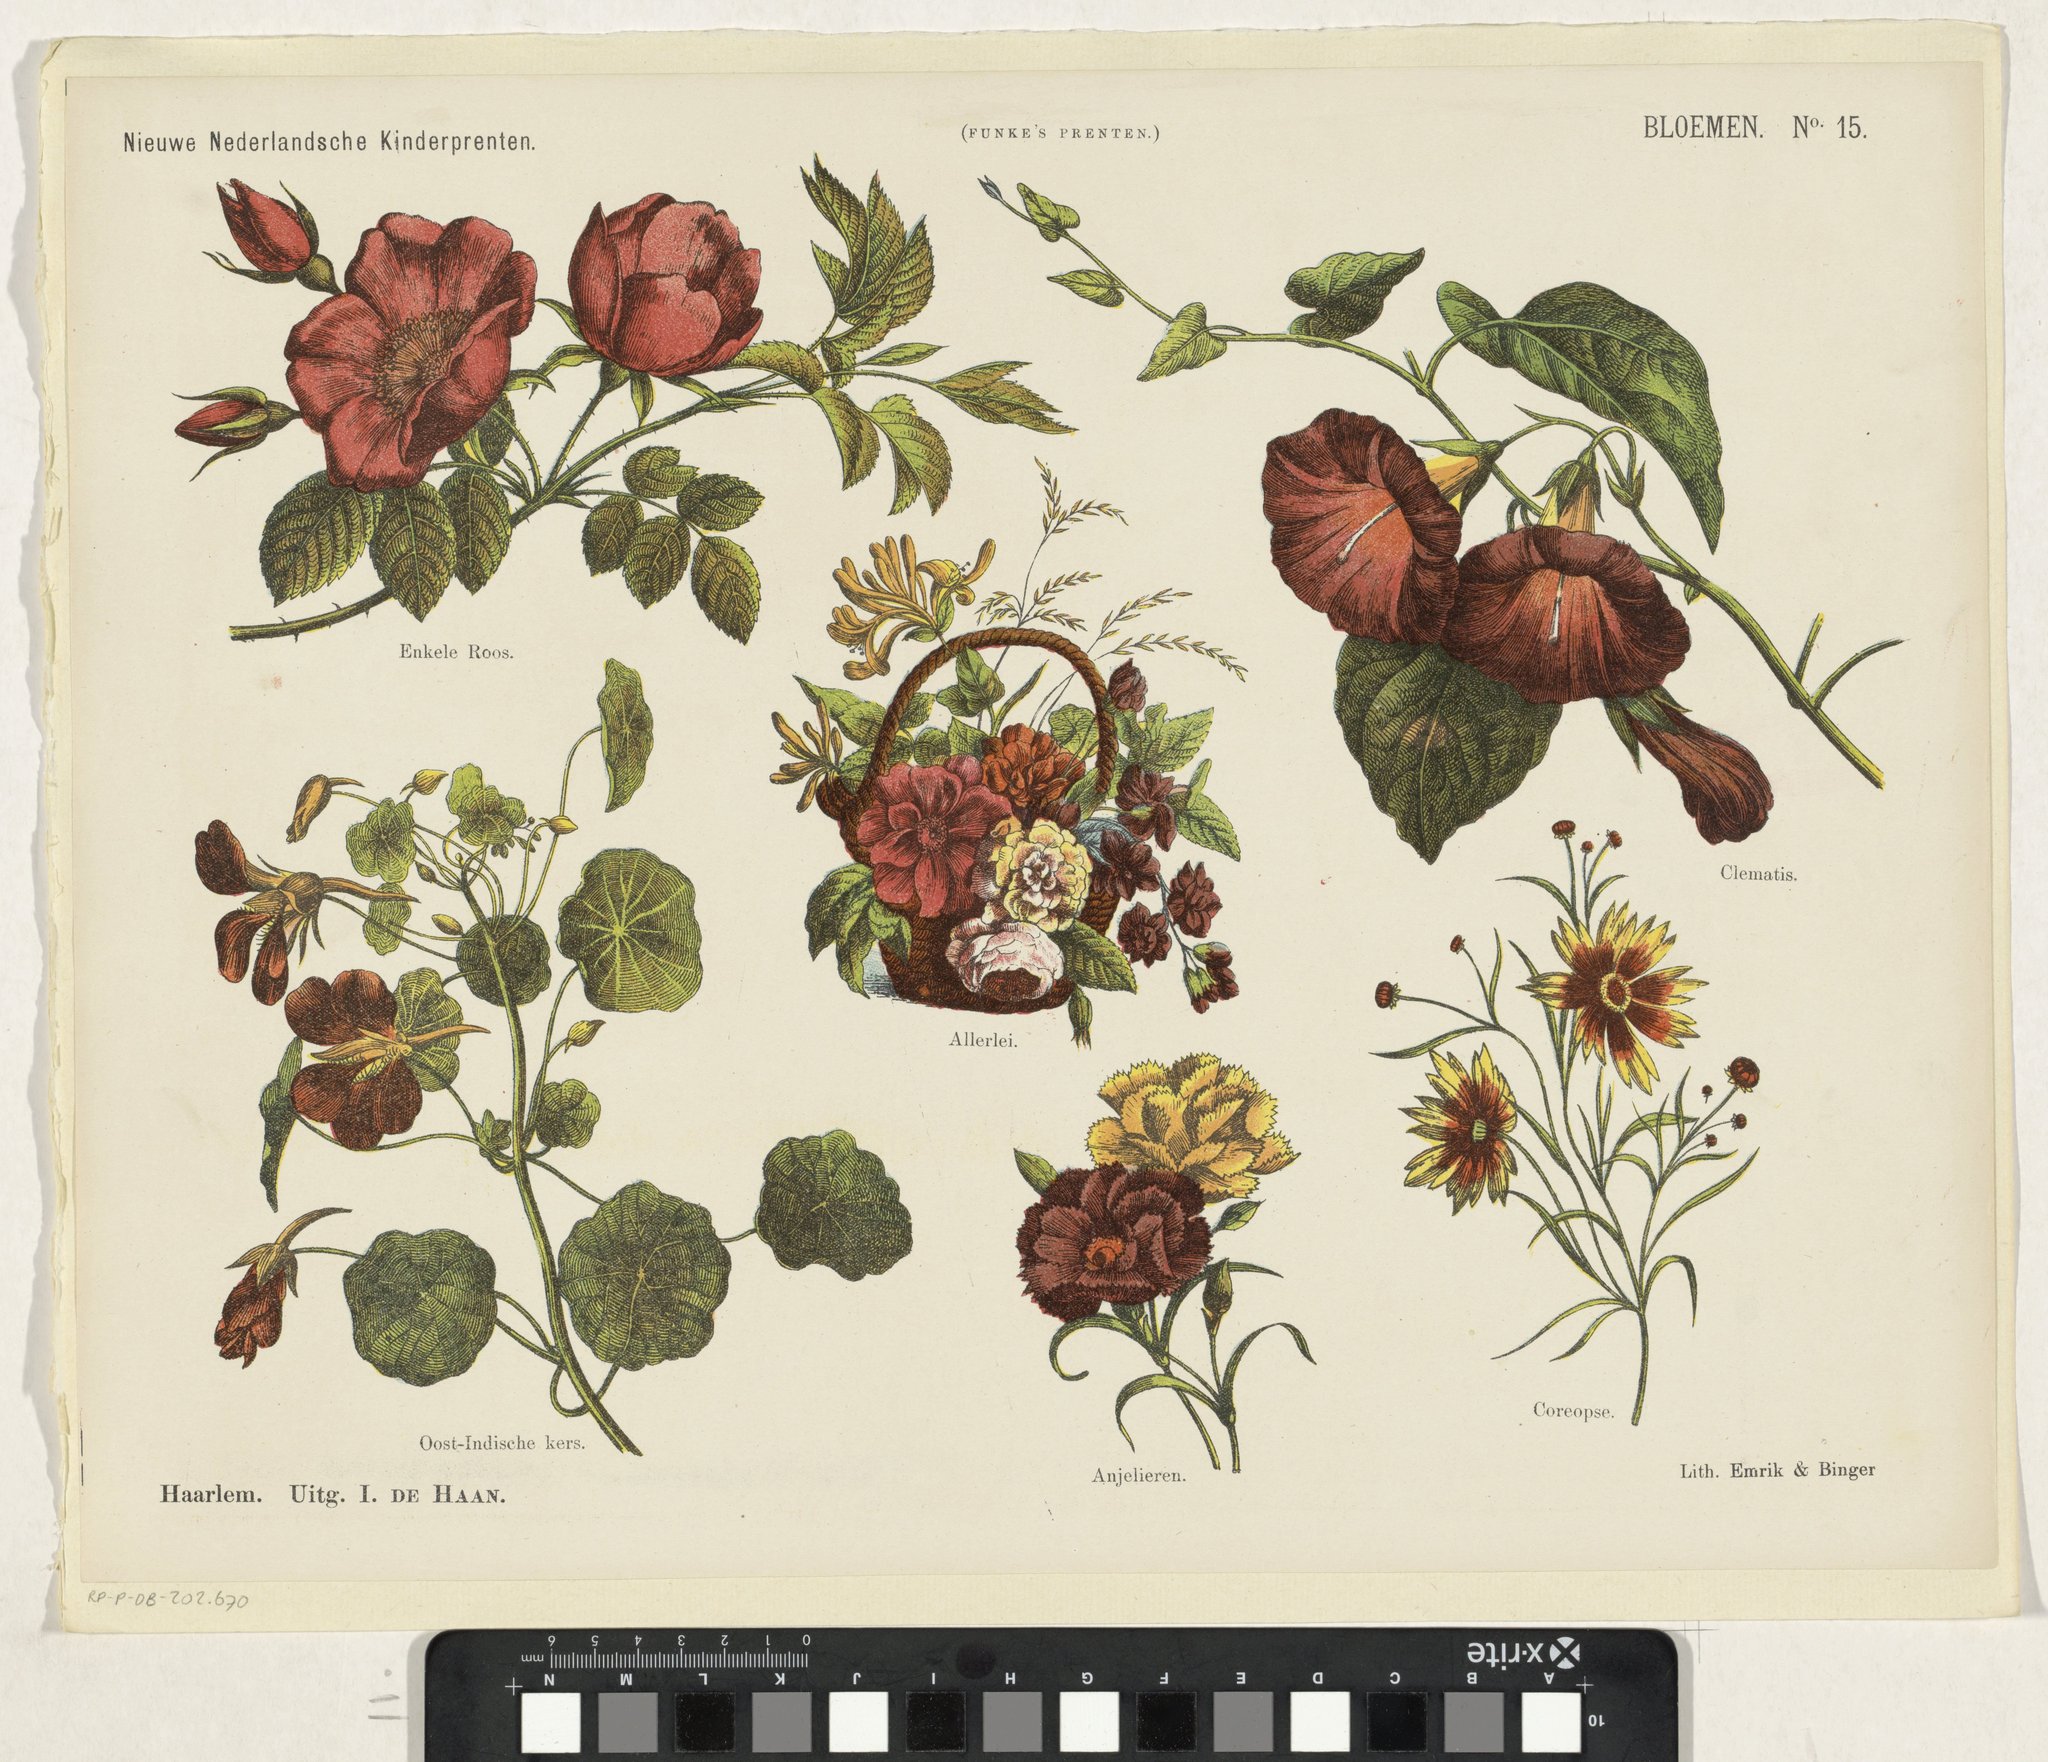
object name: print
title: Funke's prenten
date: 1875-1903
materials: paper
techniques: lithograph, letterpress printing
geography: haarlem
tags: flowers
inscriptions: collector's mark: Lugt 2760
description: Blad met 6 voorstellingen van verschillende bloemen, onder andere rozen en clematissen. Onder elke voorstelling een onderschrift. Genummerd rechtsboven: No. 15.